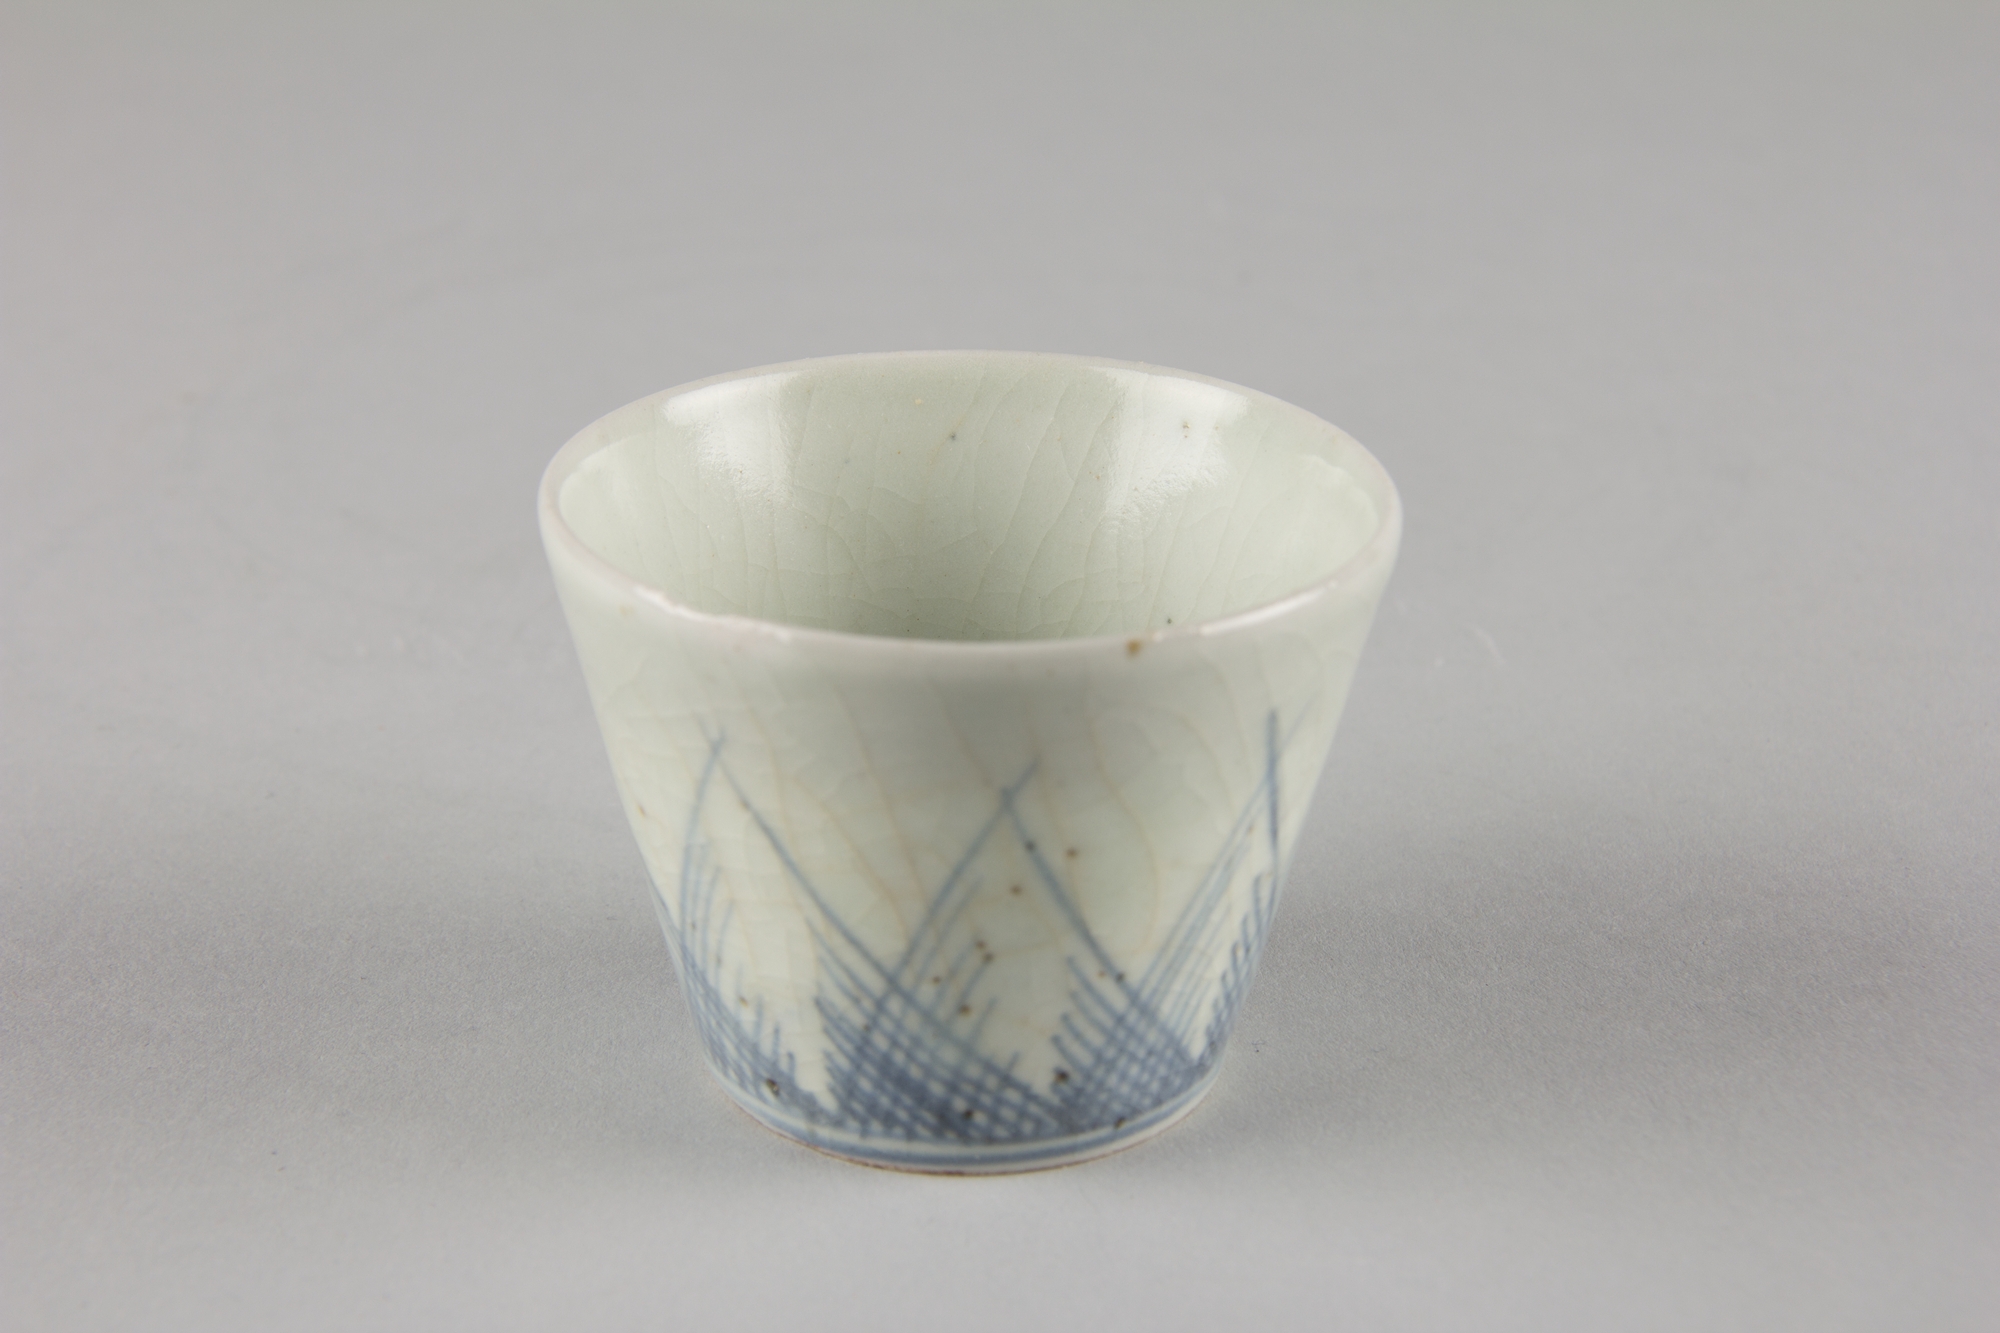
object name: soba cup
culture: japanese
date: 1734-1800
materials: porcelain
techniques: underglaze